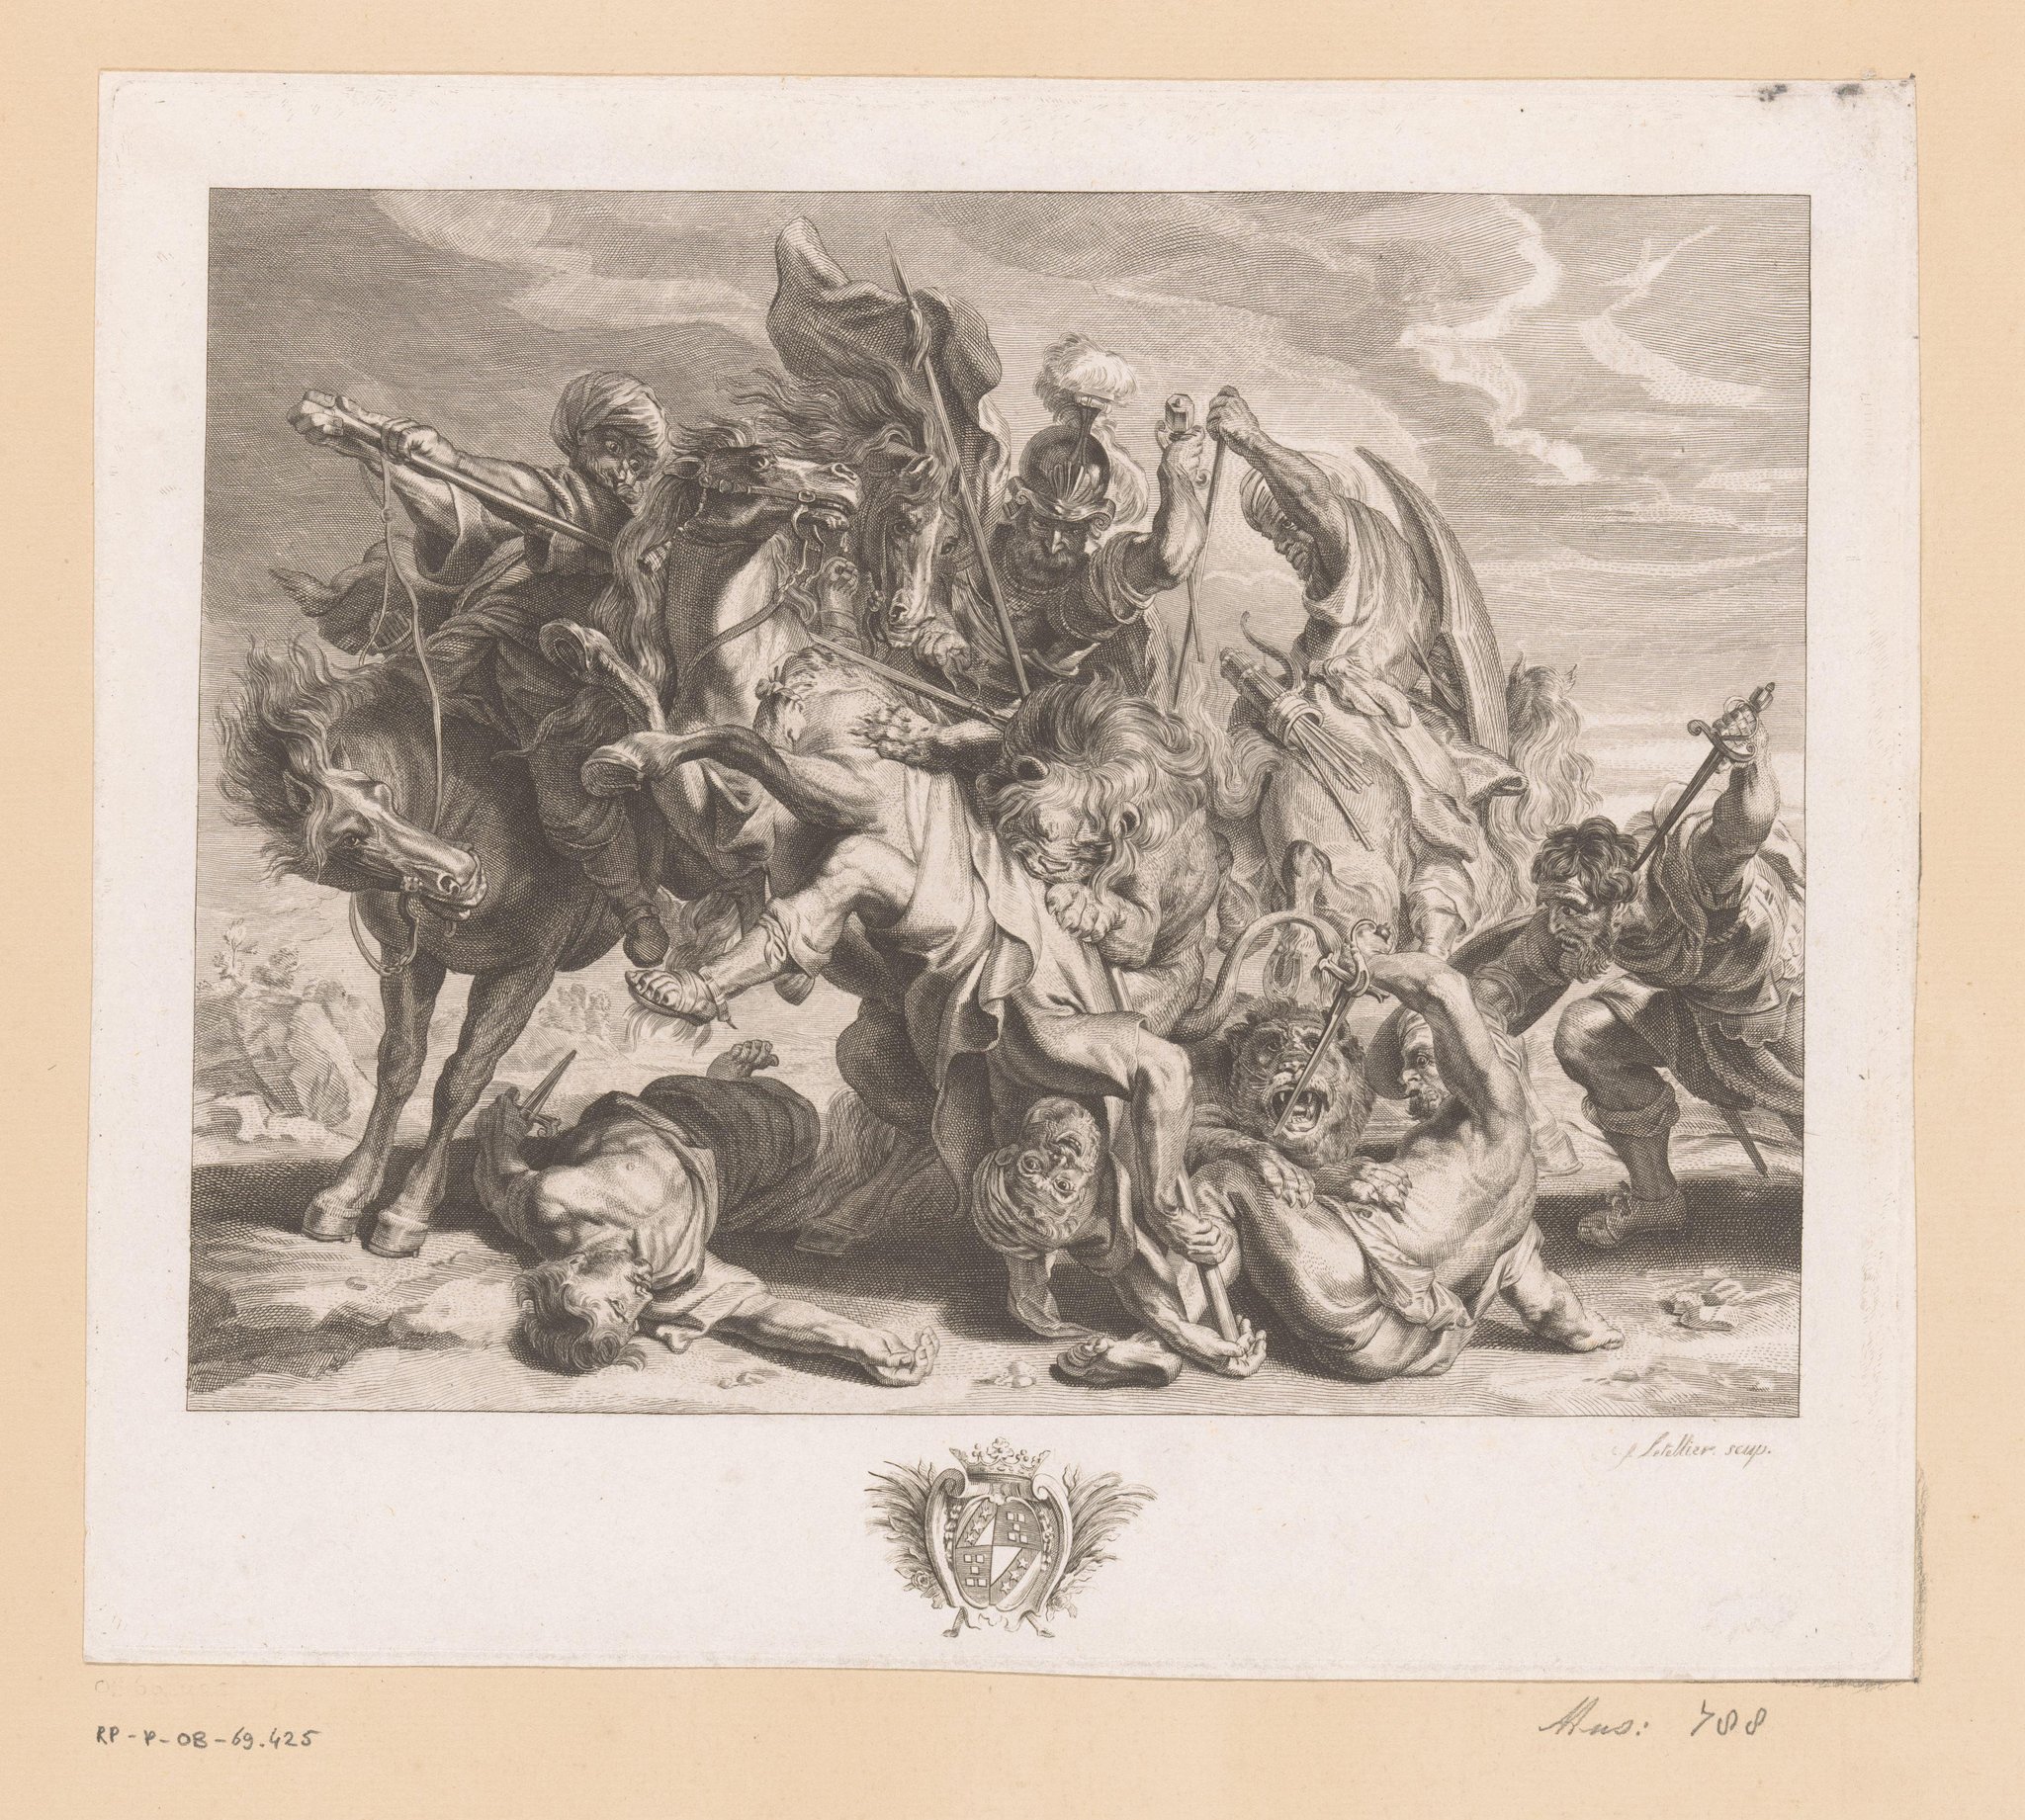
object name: print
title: Leeuwenjacht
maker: charles françois letellier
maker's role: print maker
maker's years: 1743-1800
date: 1753-1800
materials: paper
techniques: engraving, etching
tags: lion hunt, armorial bearing, heraldry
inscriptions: collector's mark: Lugt 240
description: Maakt mogelijk deel uit van een vierdelige serie met jachtscènes, opgedragen aan de Comte de Buffon. Zie British Museum, inv.nr. 1891,0414.1252.